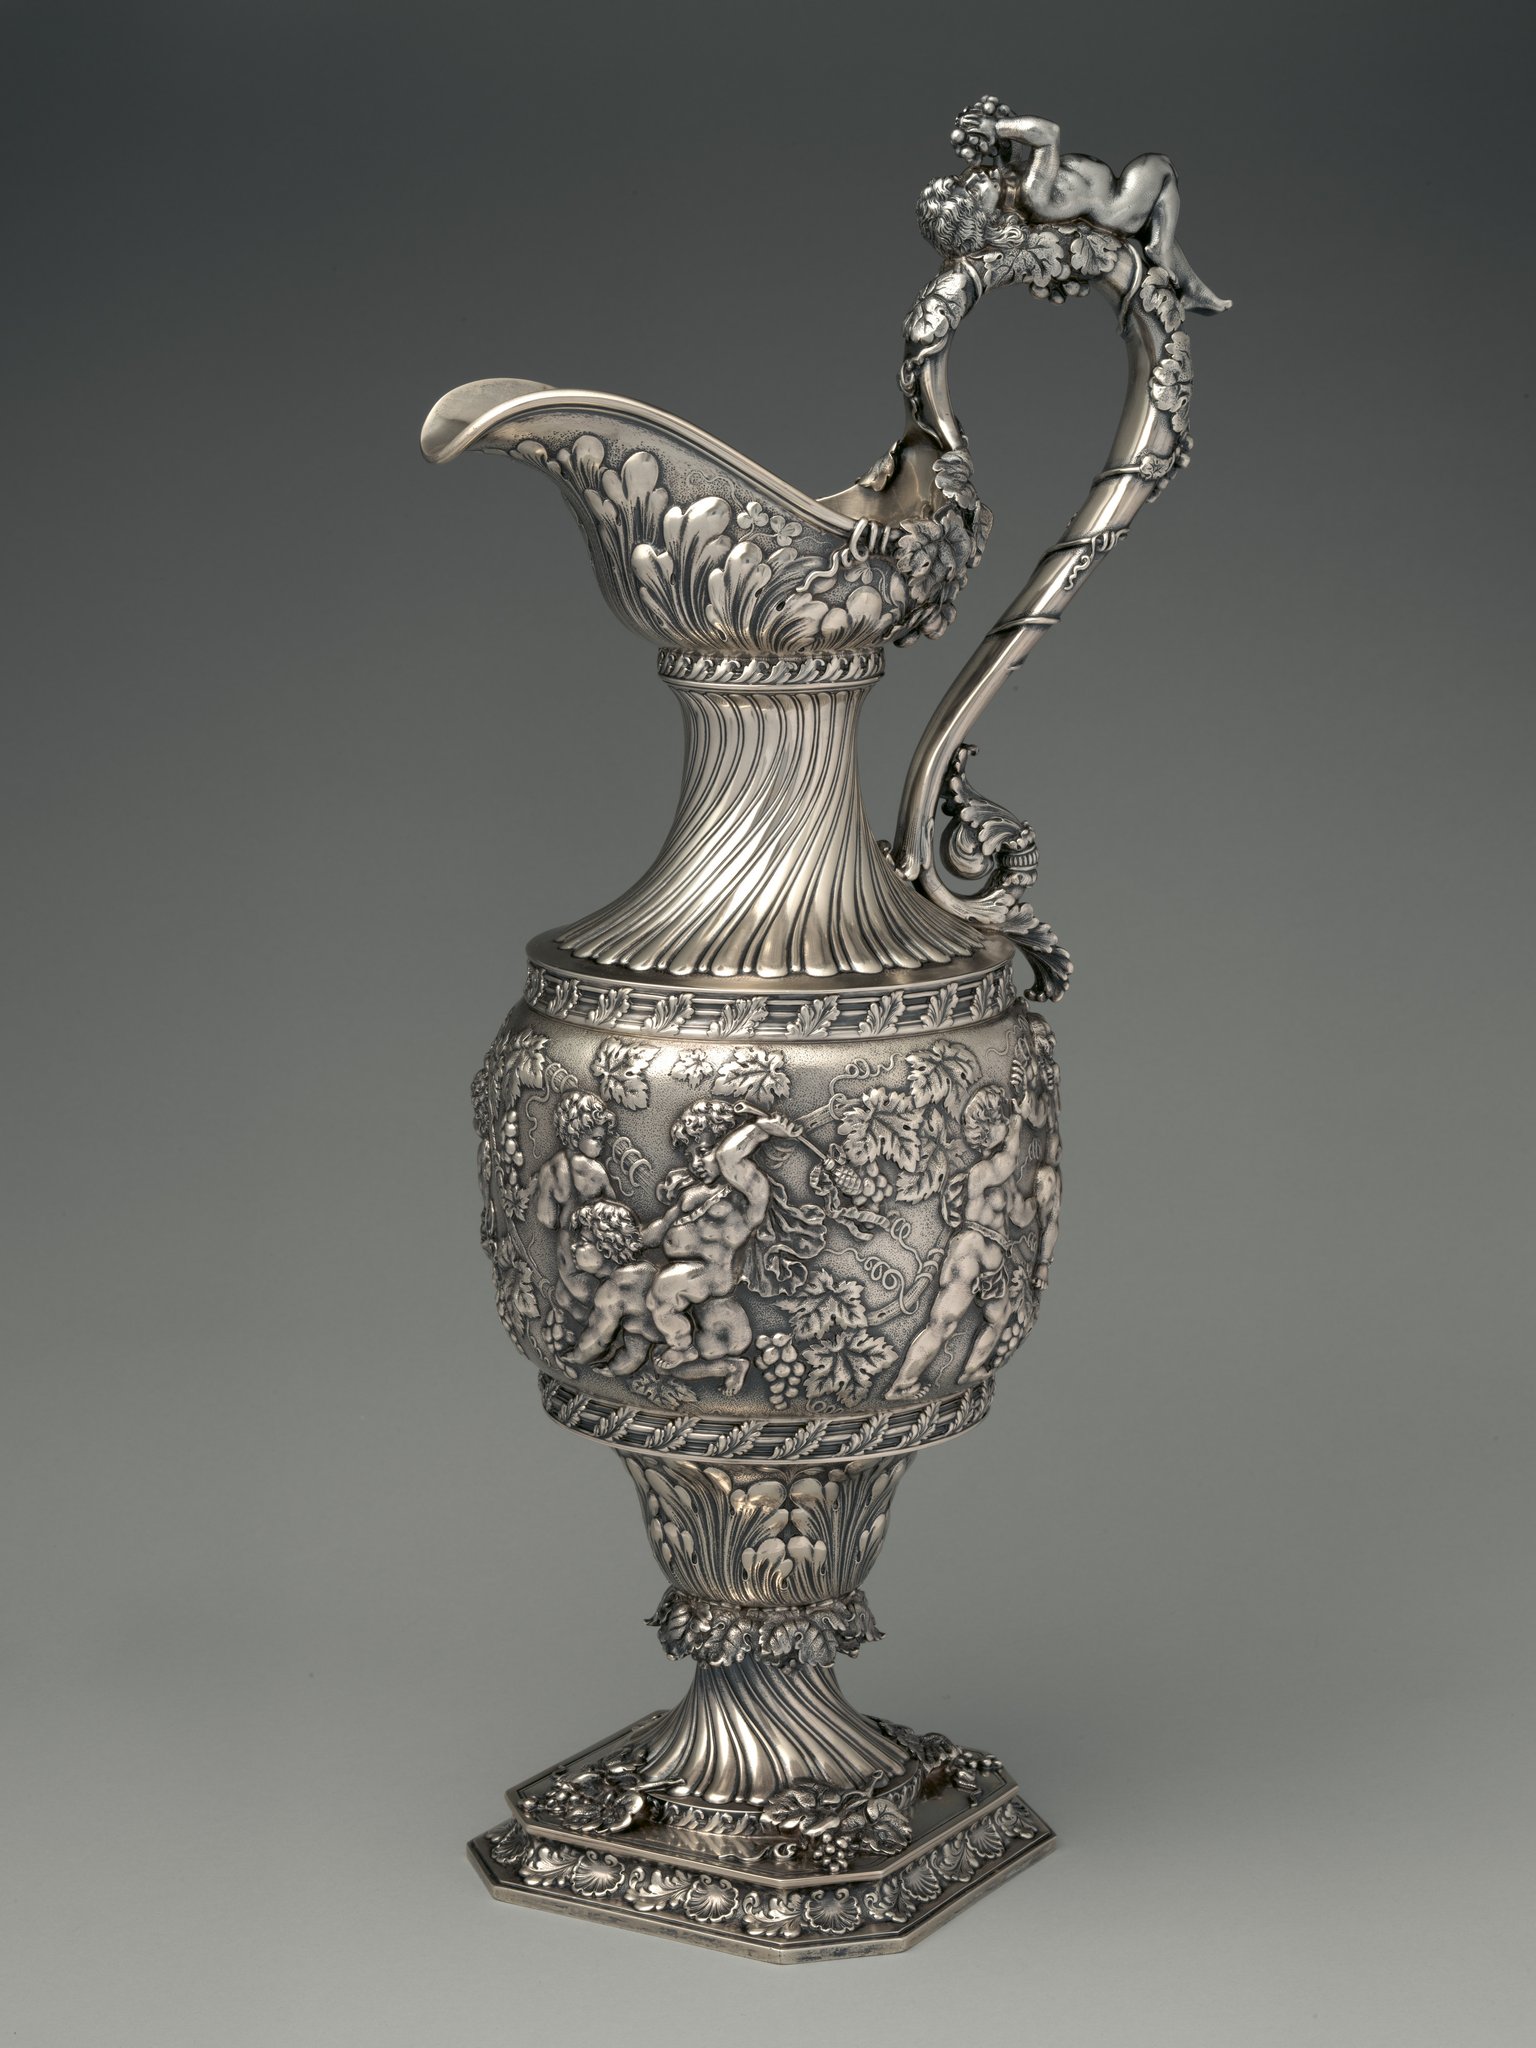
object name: pitcher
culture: american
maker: tiffany & co.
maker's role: maker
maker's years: 1837-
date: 1882-1889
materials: silver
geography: united states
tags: grapes,putti